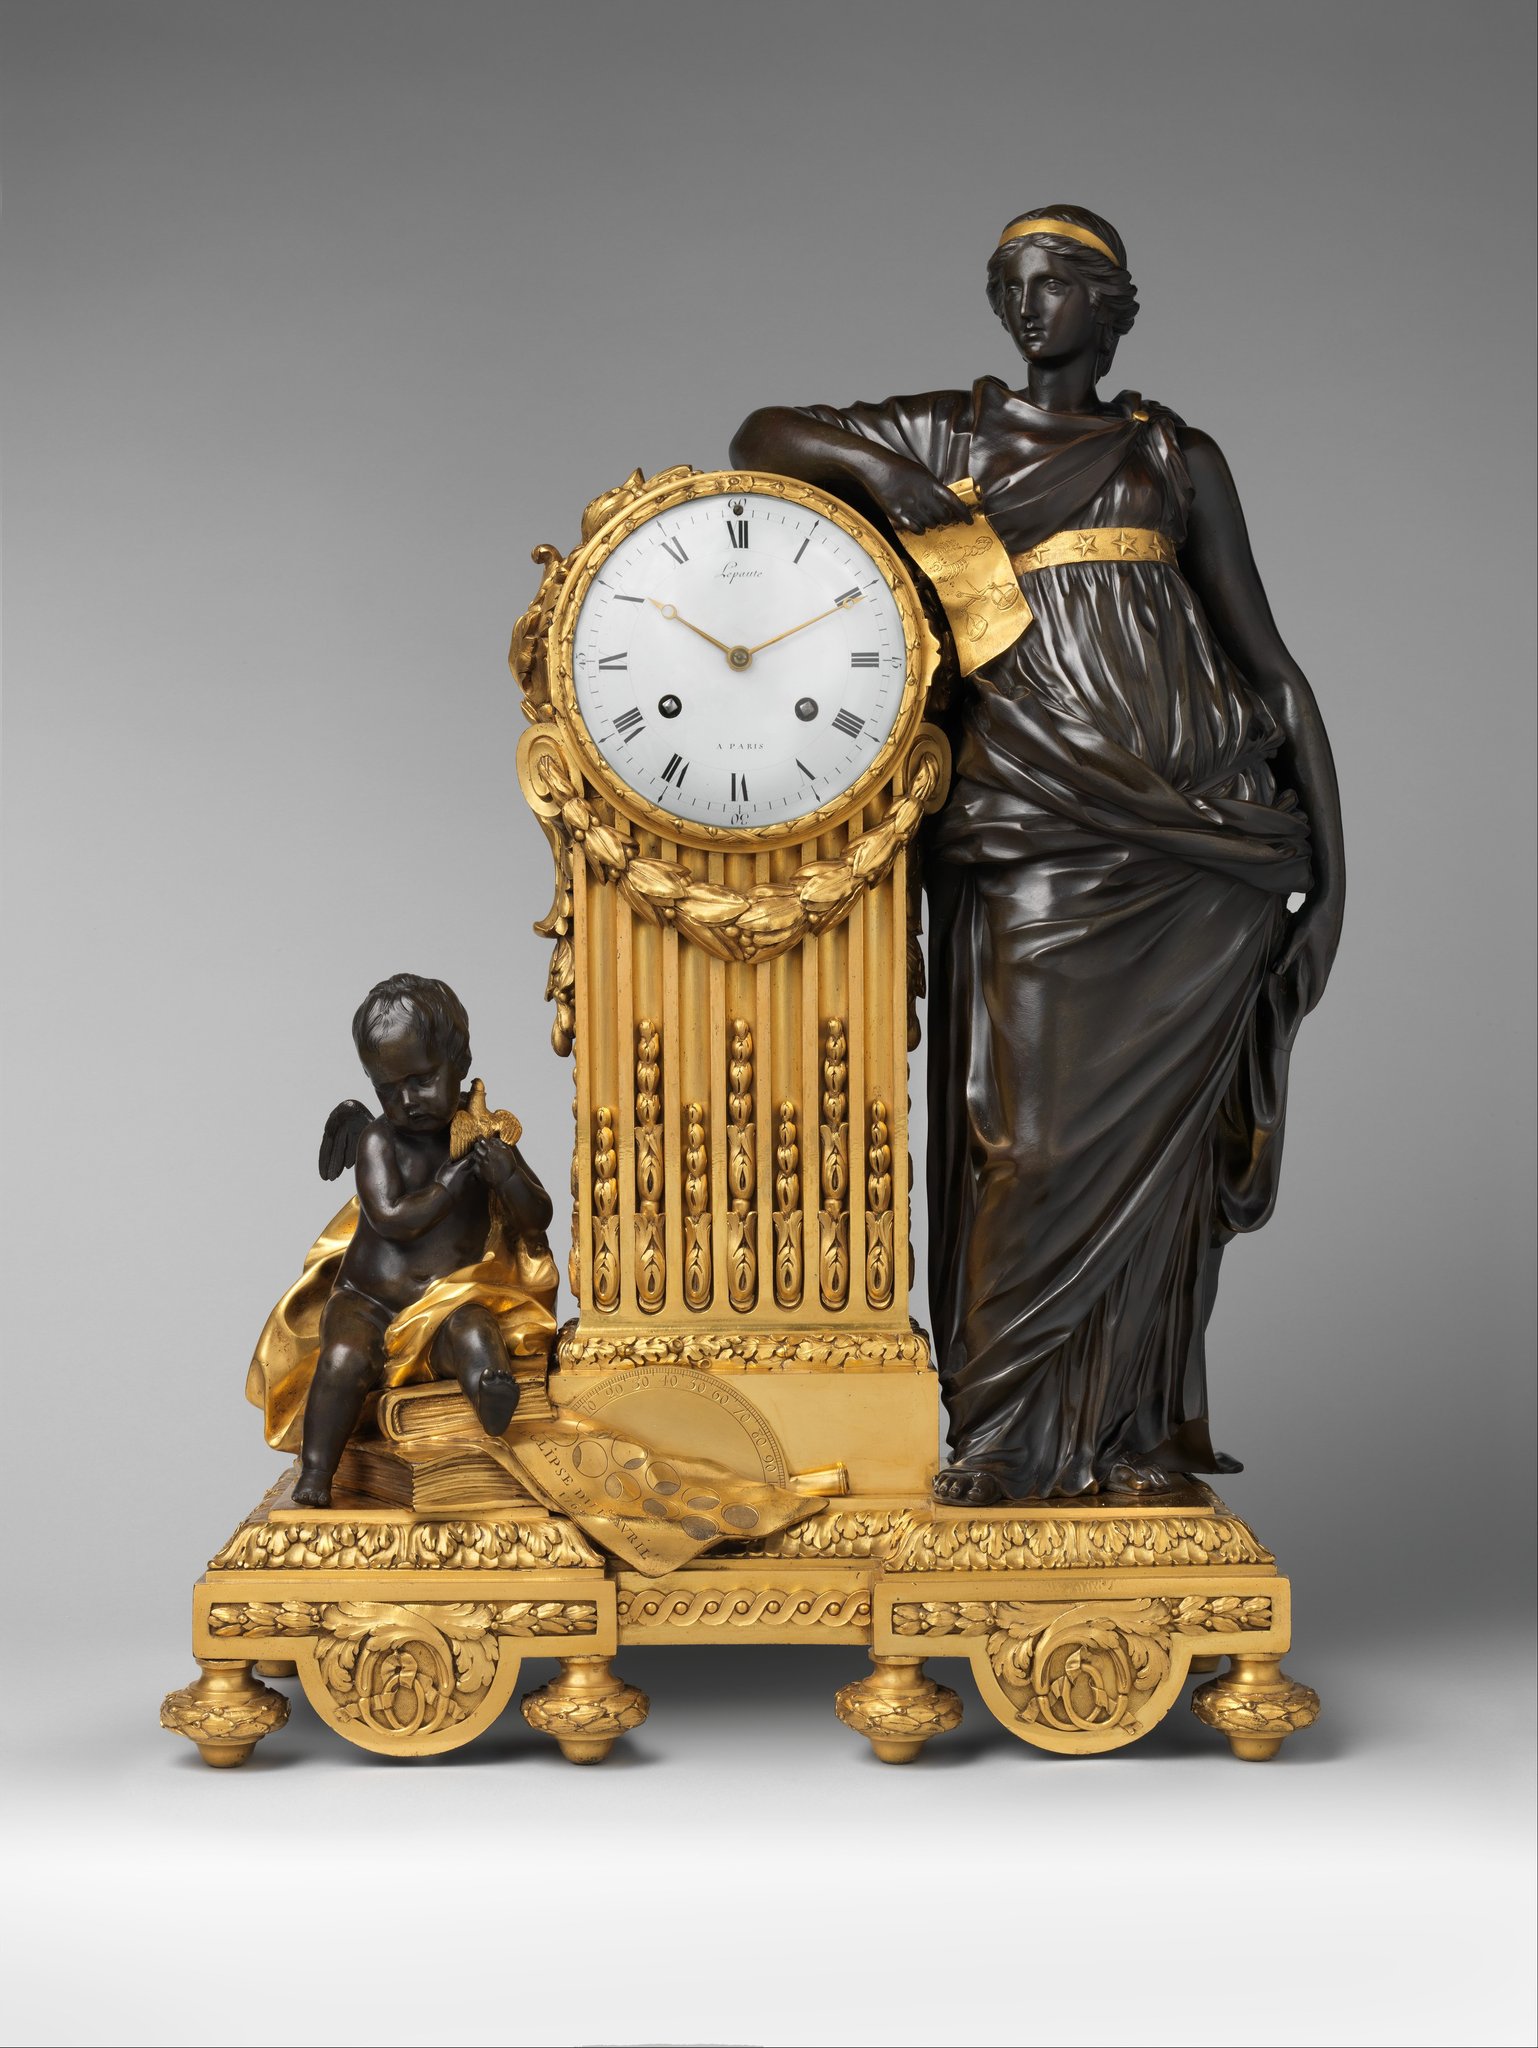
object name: mantel clock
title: Mantel clock ("Pendule Uranie")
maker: jean-andré lepaute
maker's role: maker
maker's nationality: french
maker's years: 1720-1789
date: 1764-1770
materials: brass, bronze, enamel, steel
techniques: gilding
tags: birds,books,women,angels